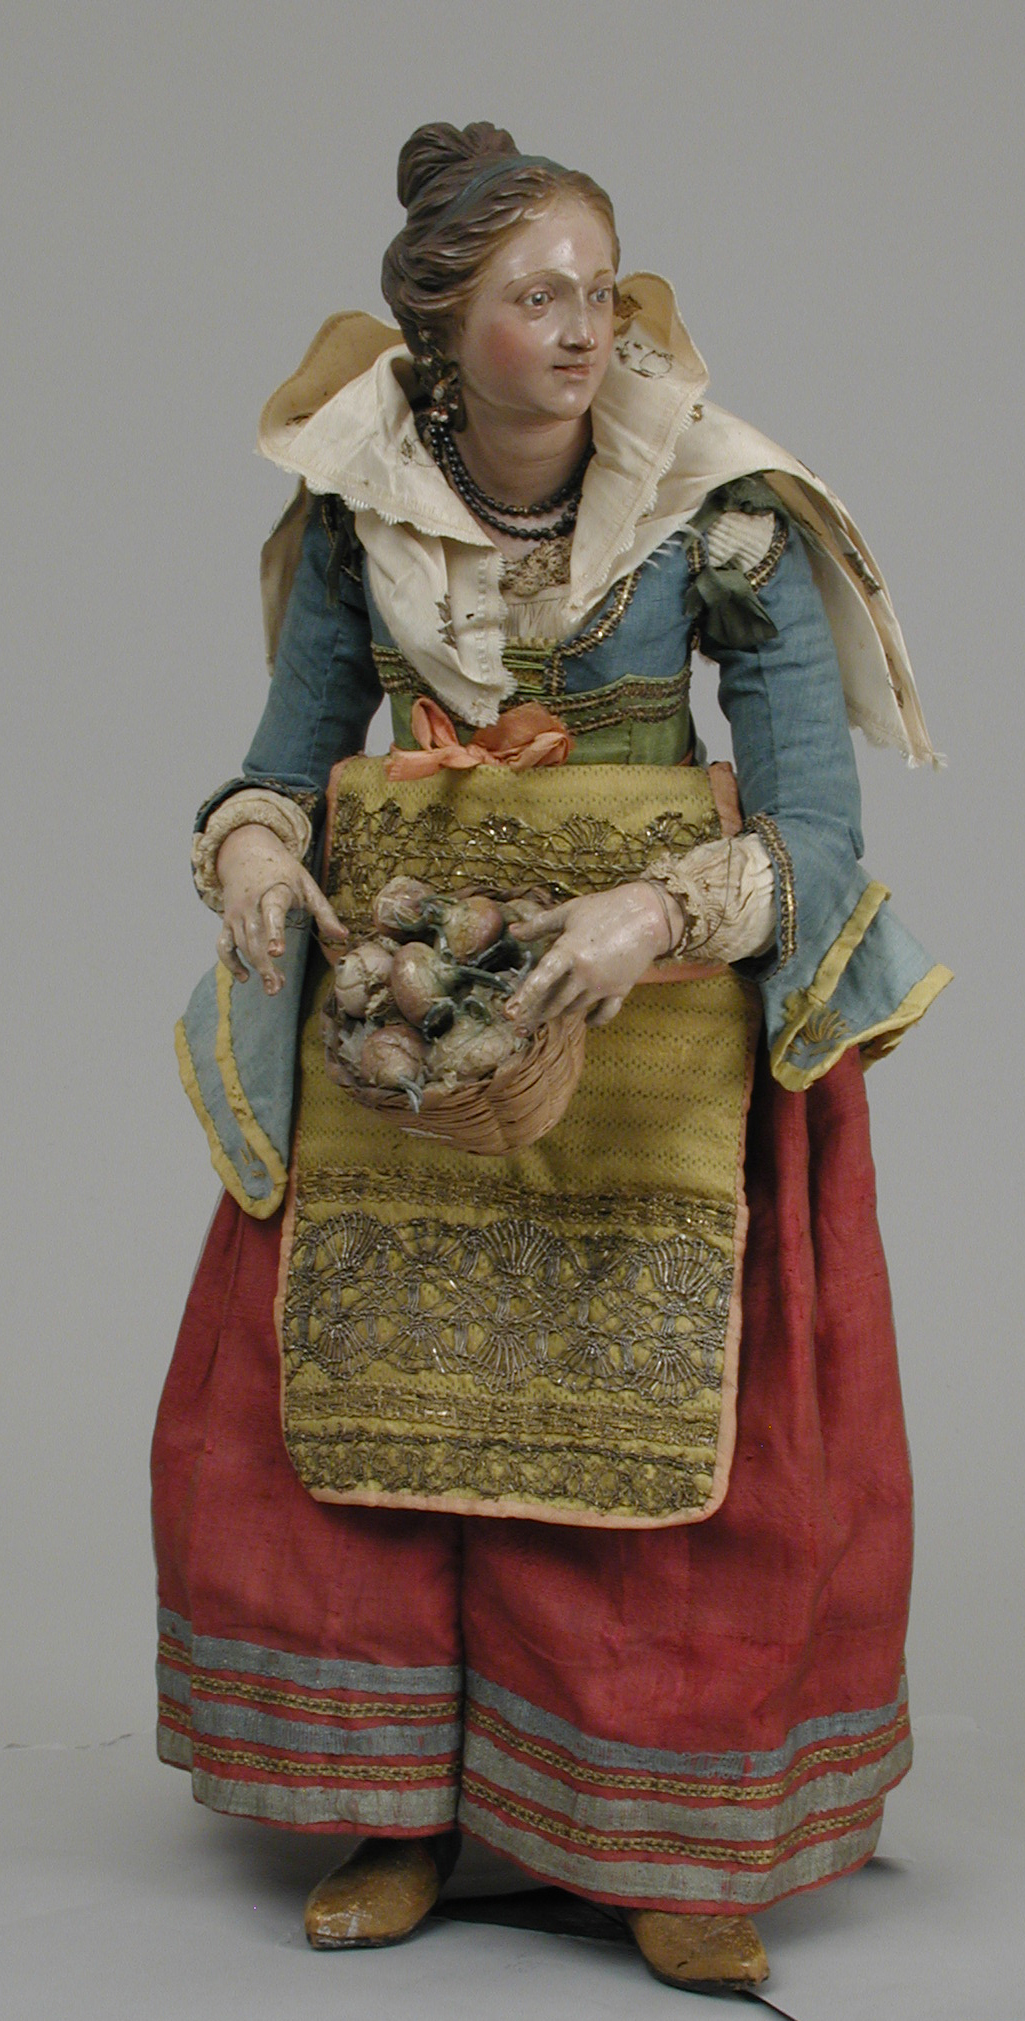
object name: crèche figure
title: Girl carrying basket of onions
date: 1701-1800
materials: textile, pearl, raffia, fiber, terracotta, wood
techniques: polychrome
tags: onions,girls